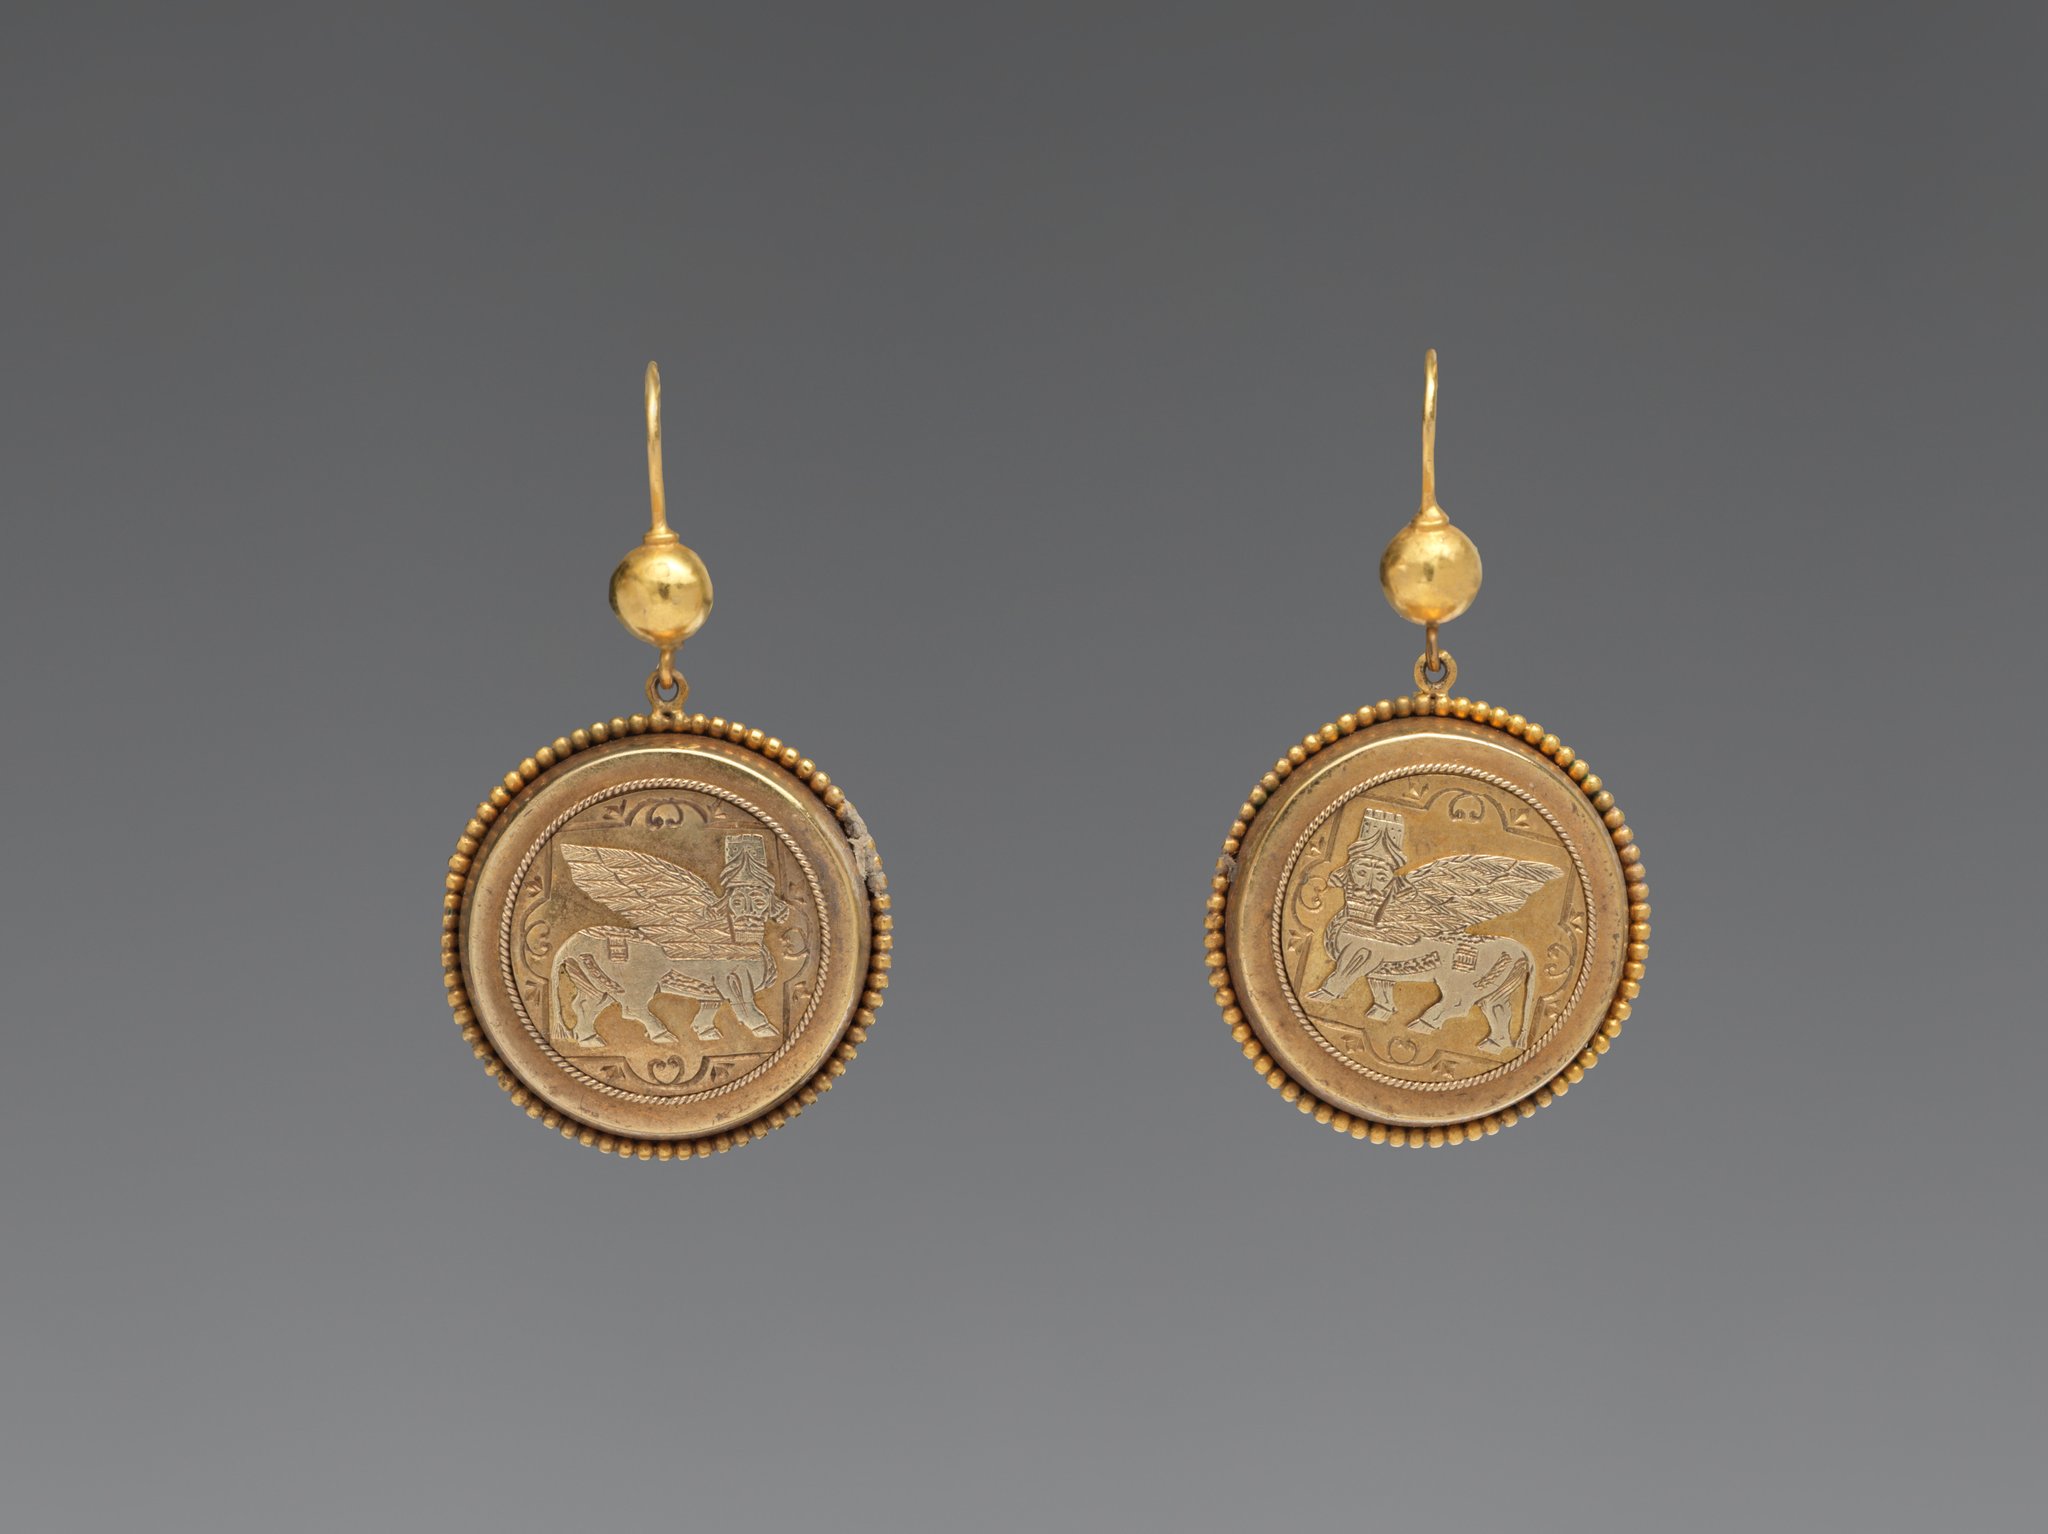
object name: earring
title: Earrings with Assyrian human-headed winged bulls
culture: british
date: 1851-1900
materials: gold